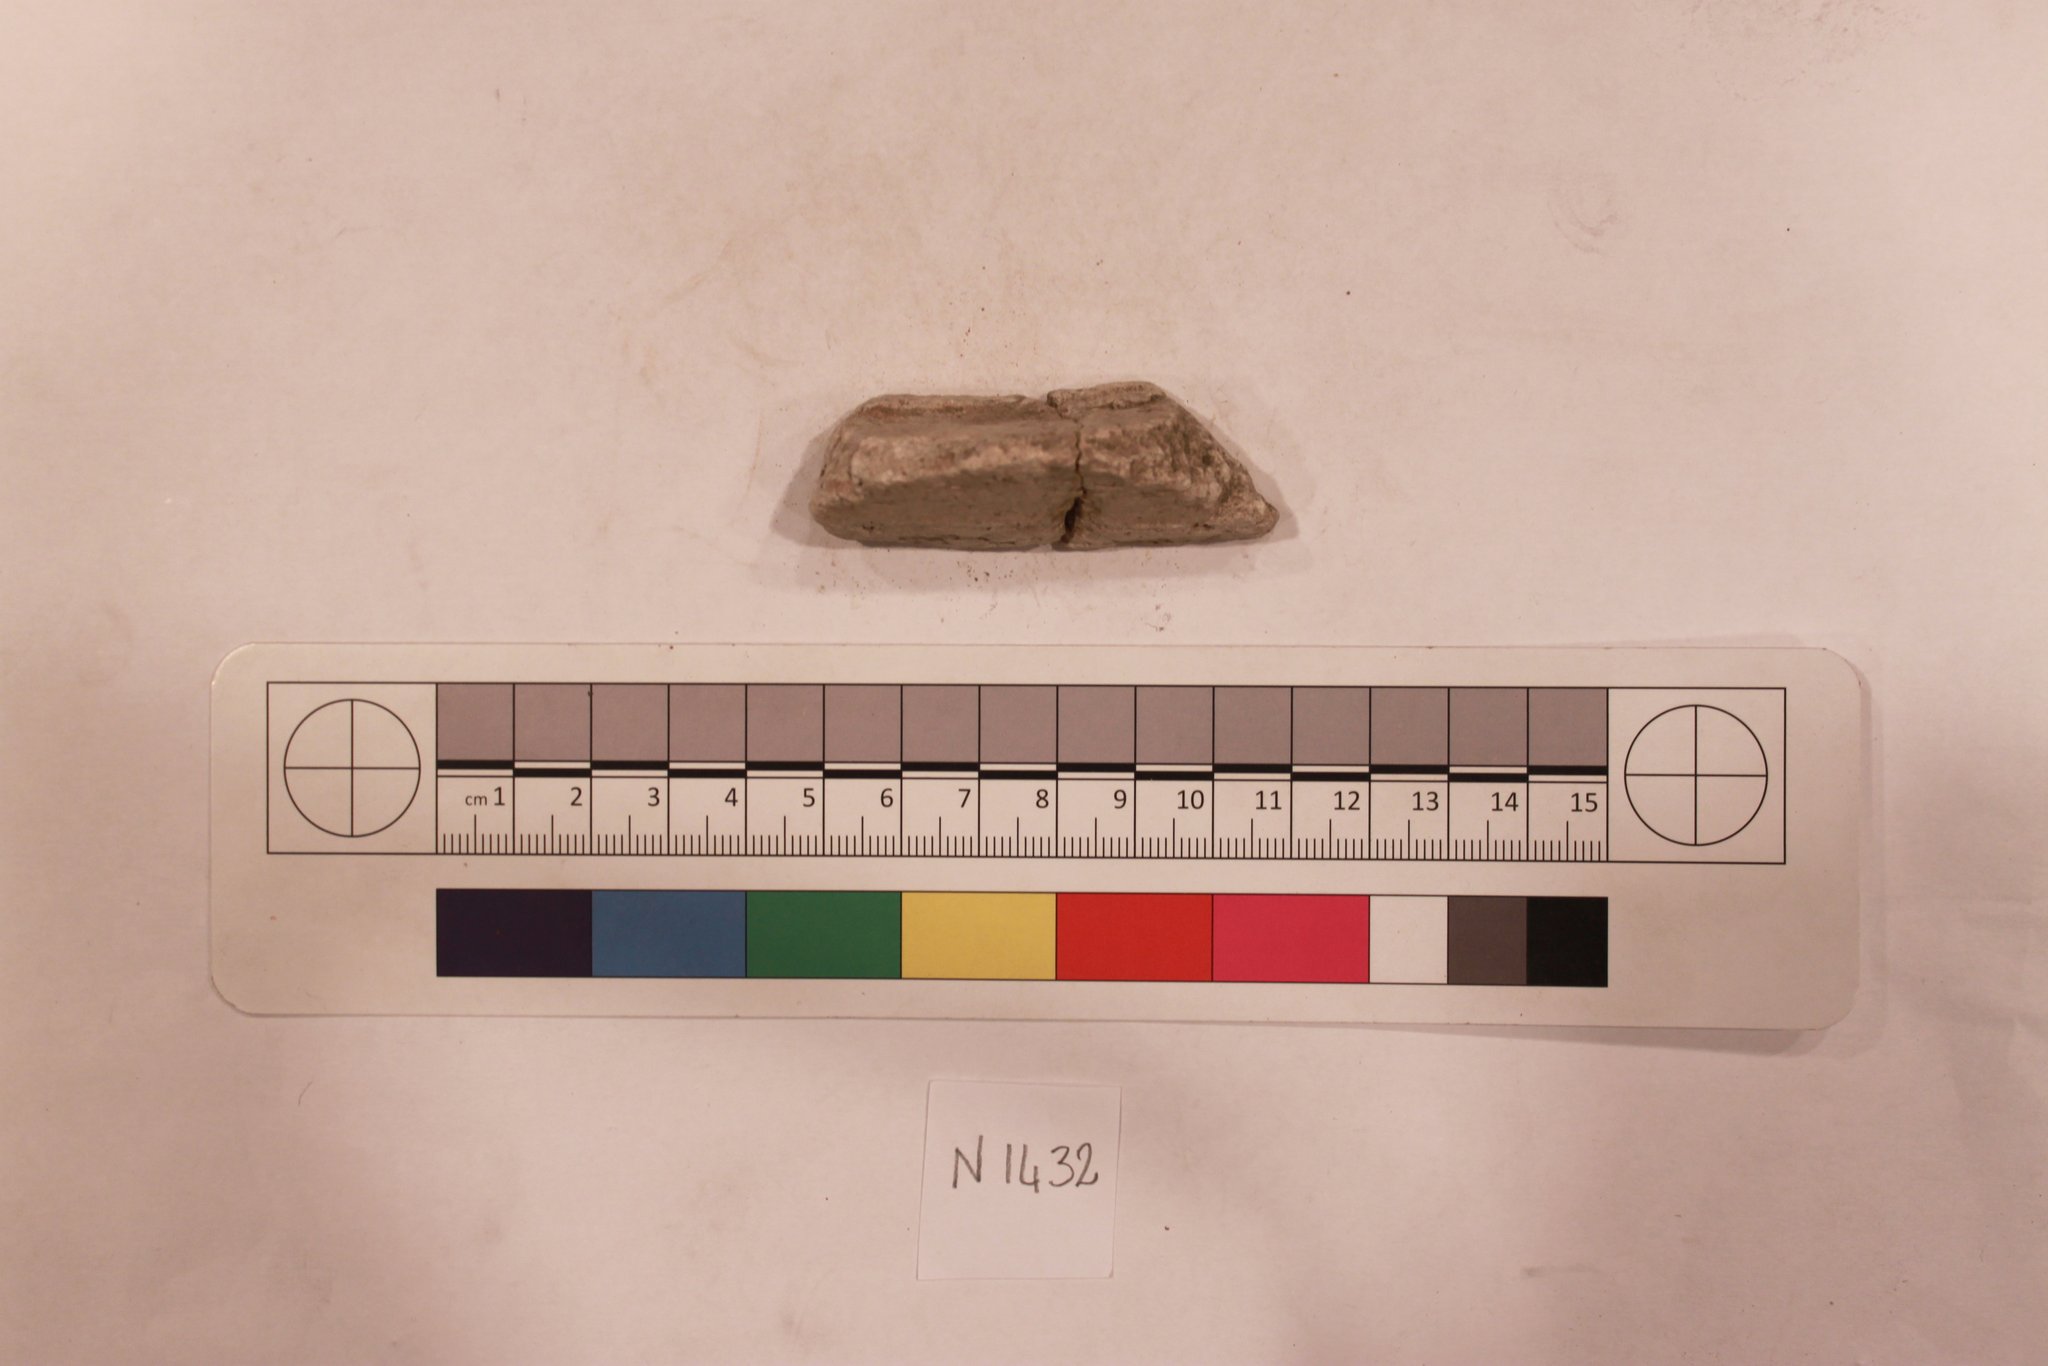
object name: fragment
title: Stucco Fragment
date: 701-1200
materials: plaster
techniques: carving, painting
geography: iran